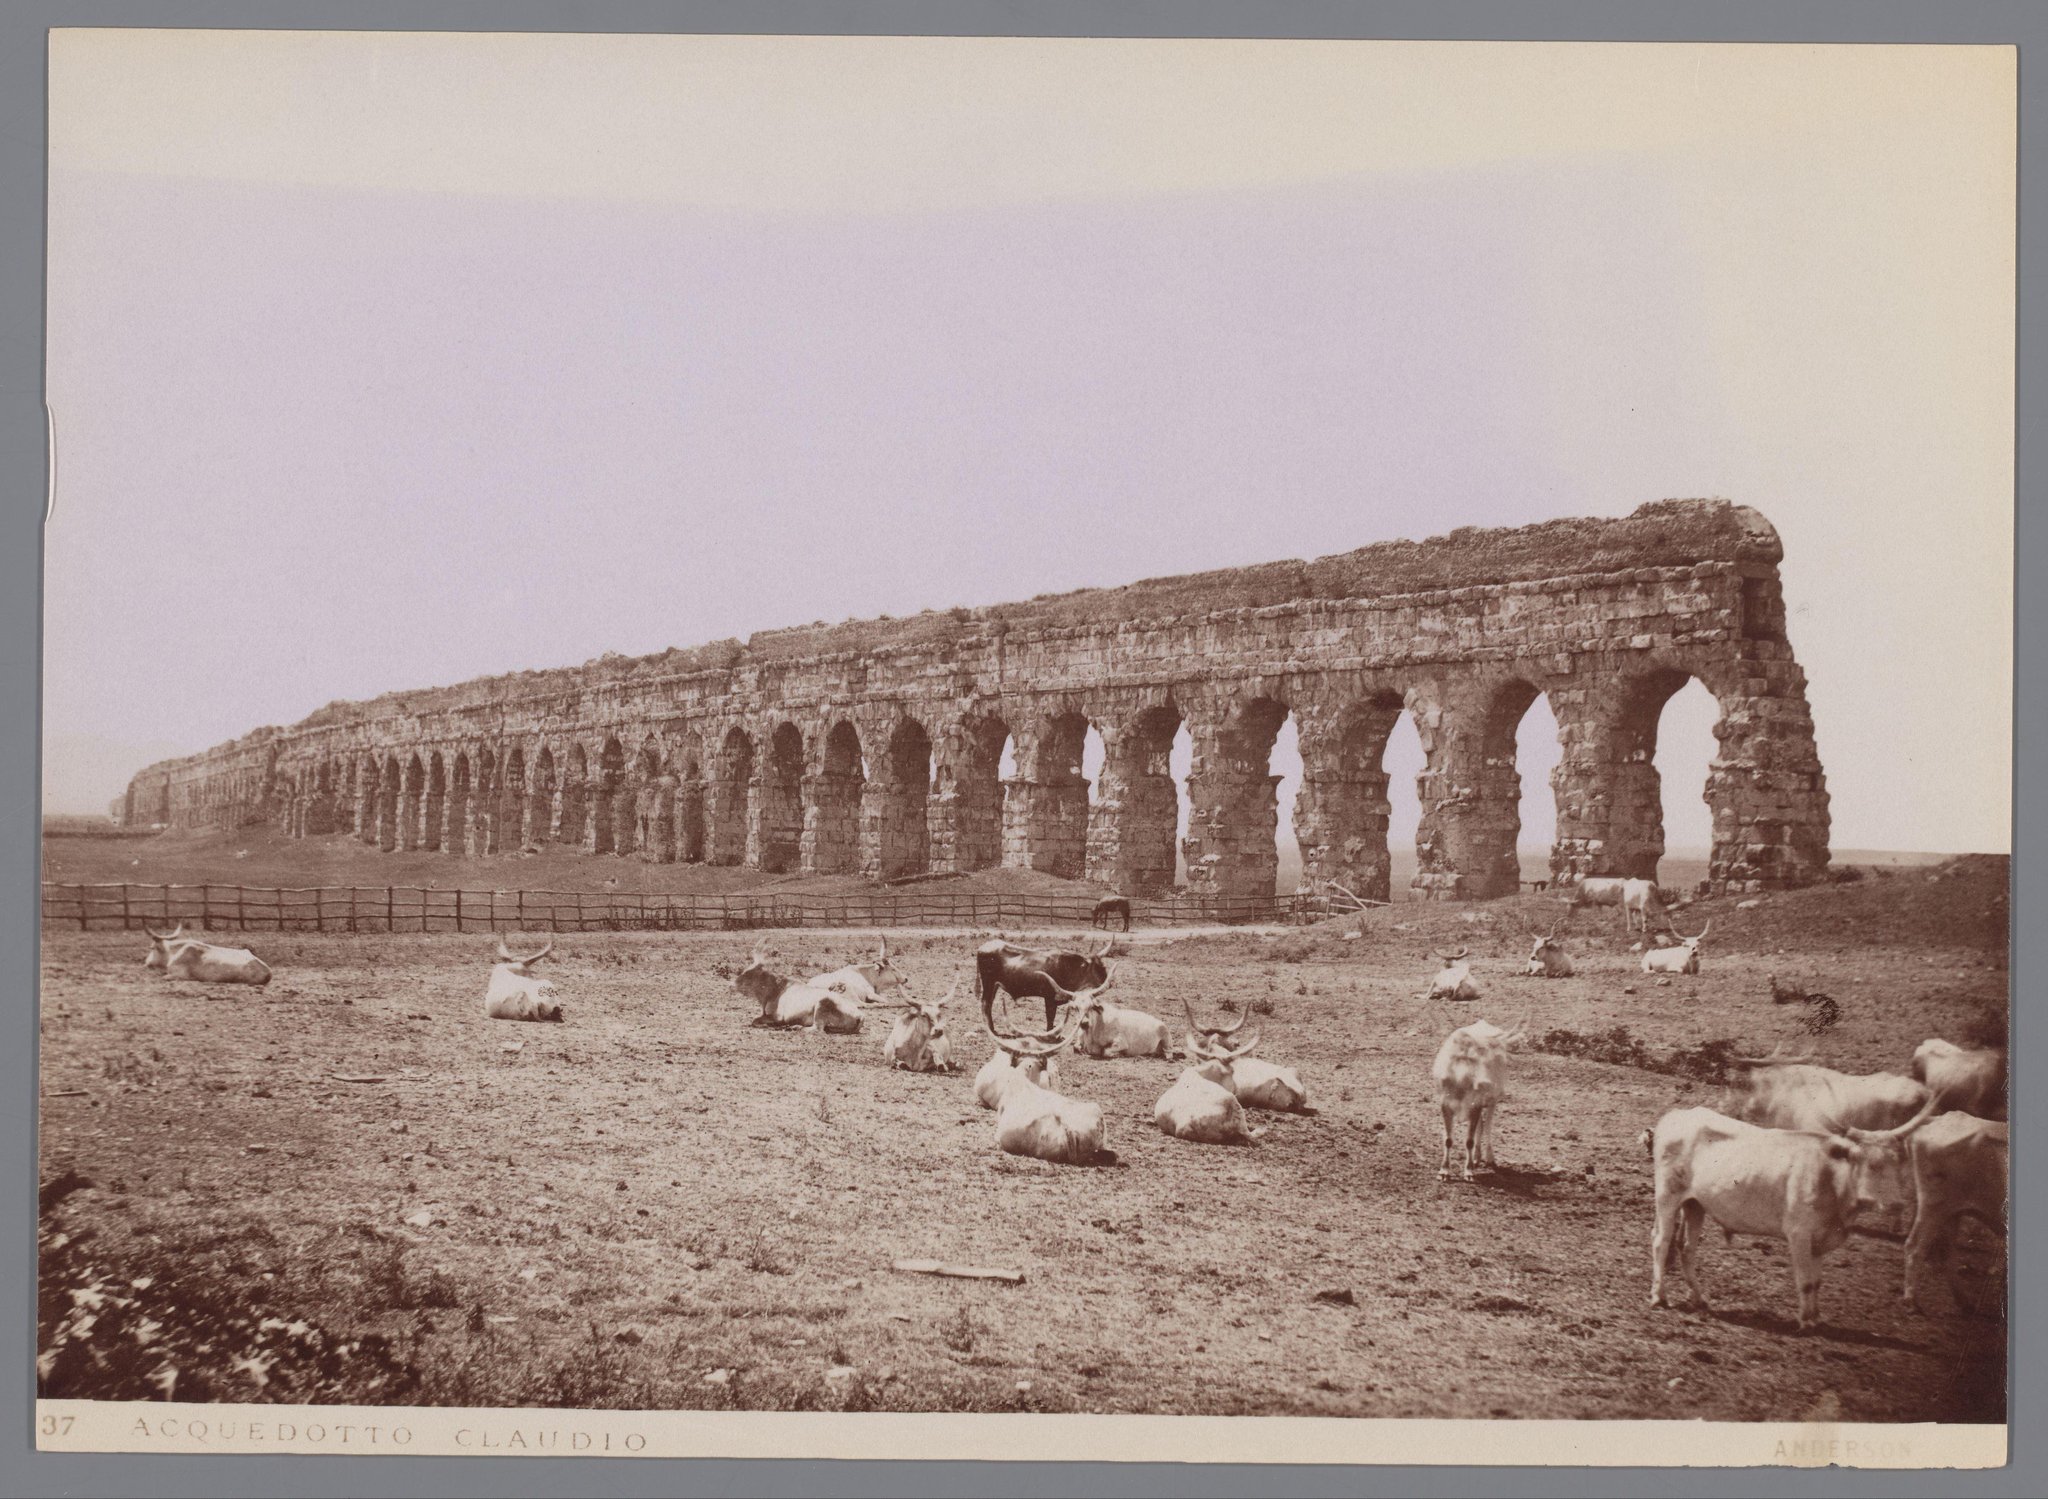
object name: photograph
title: Acquedotto Claudia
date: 1860-1900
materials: paper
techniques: albumen print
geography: rome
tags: aqueduct (~ water supply)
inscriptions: collector's mark: ‘VOSMAER’, number: ‘[...]37’